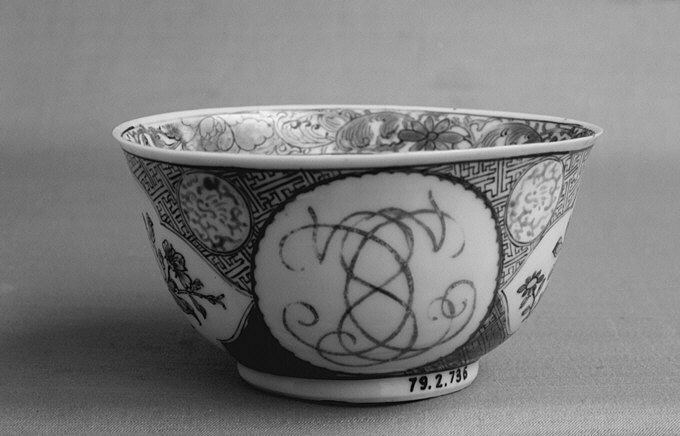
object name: teabowl and saucer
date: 1730-1735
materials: hard paste porcelain